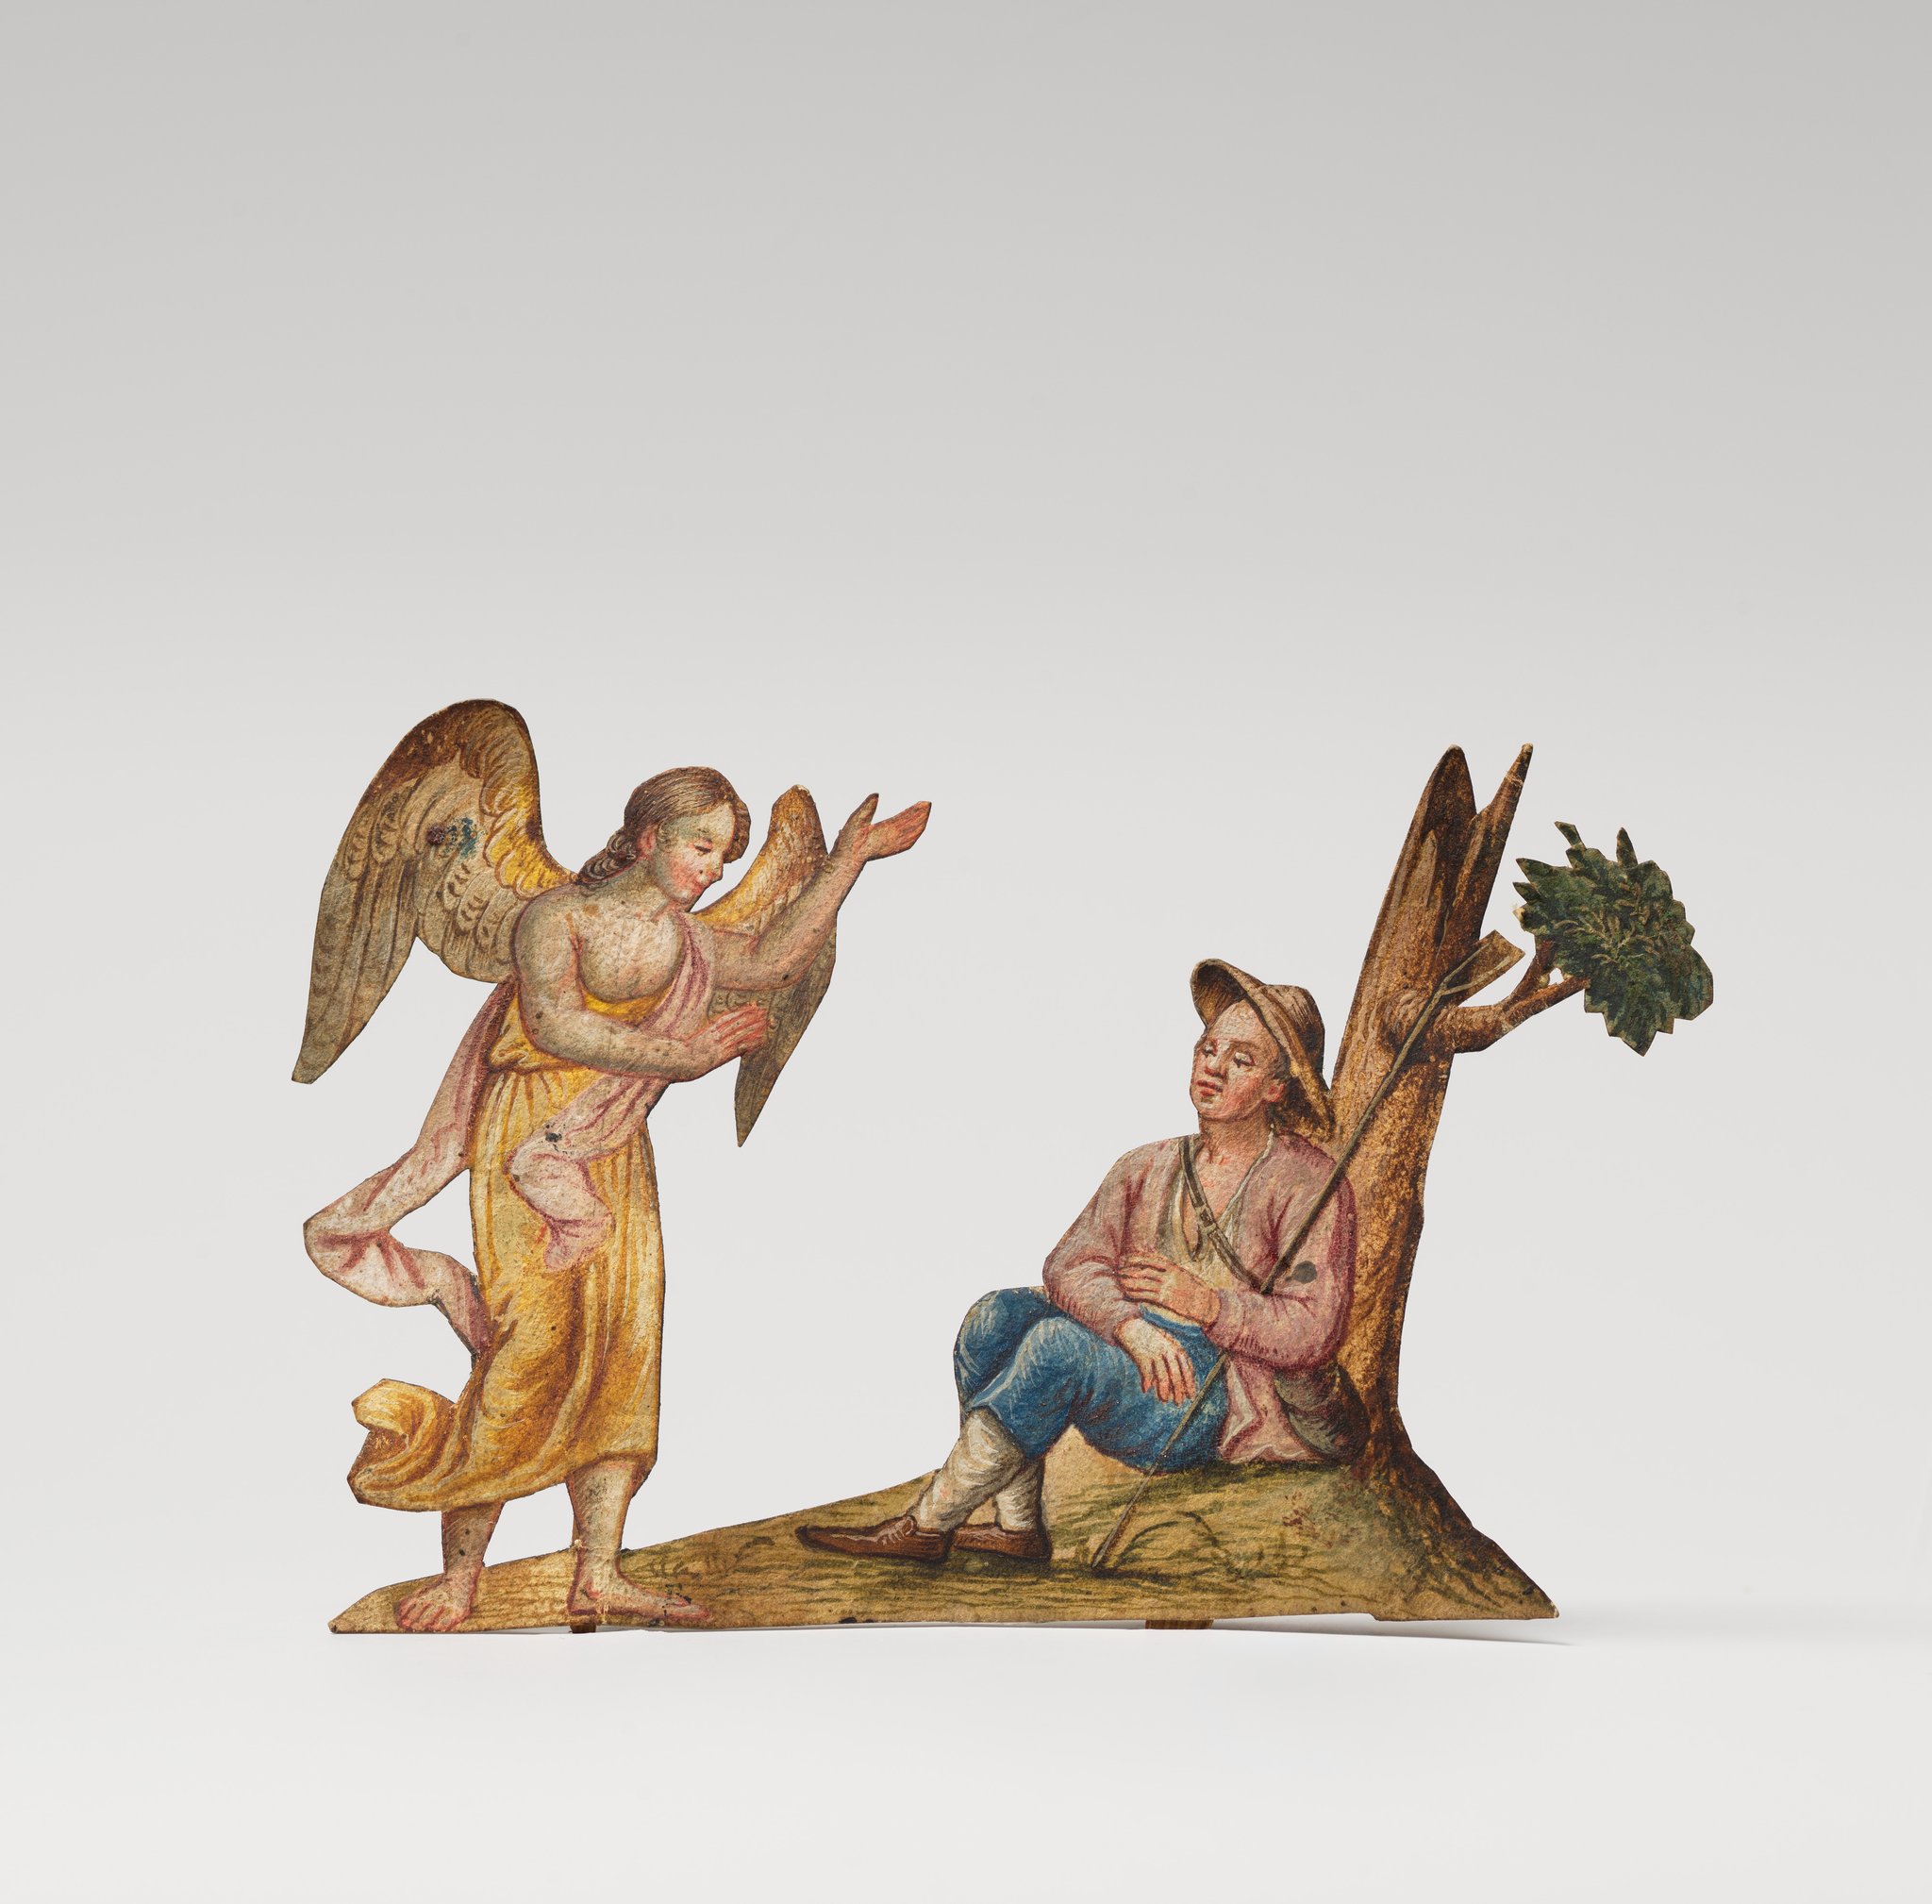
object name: figure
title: Angel Appearing to Seated Shepherd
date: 1701-1800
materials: gouache, paper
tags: angels,shepherds